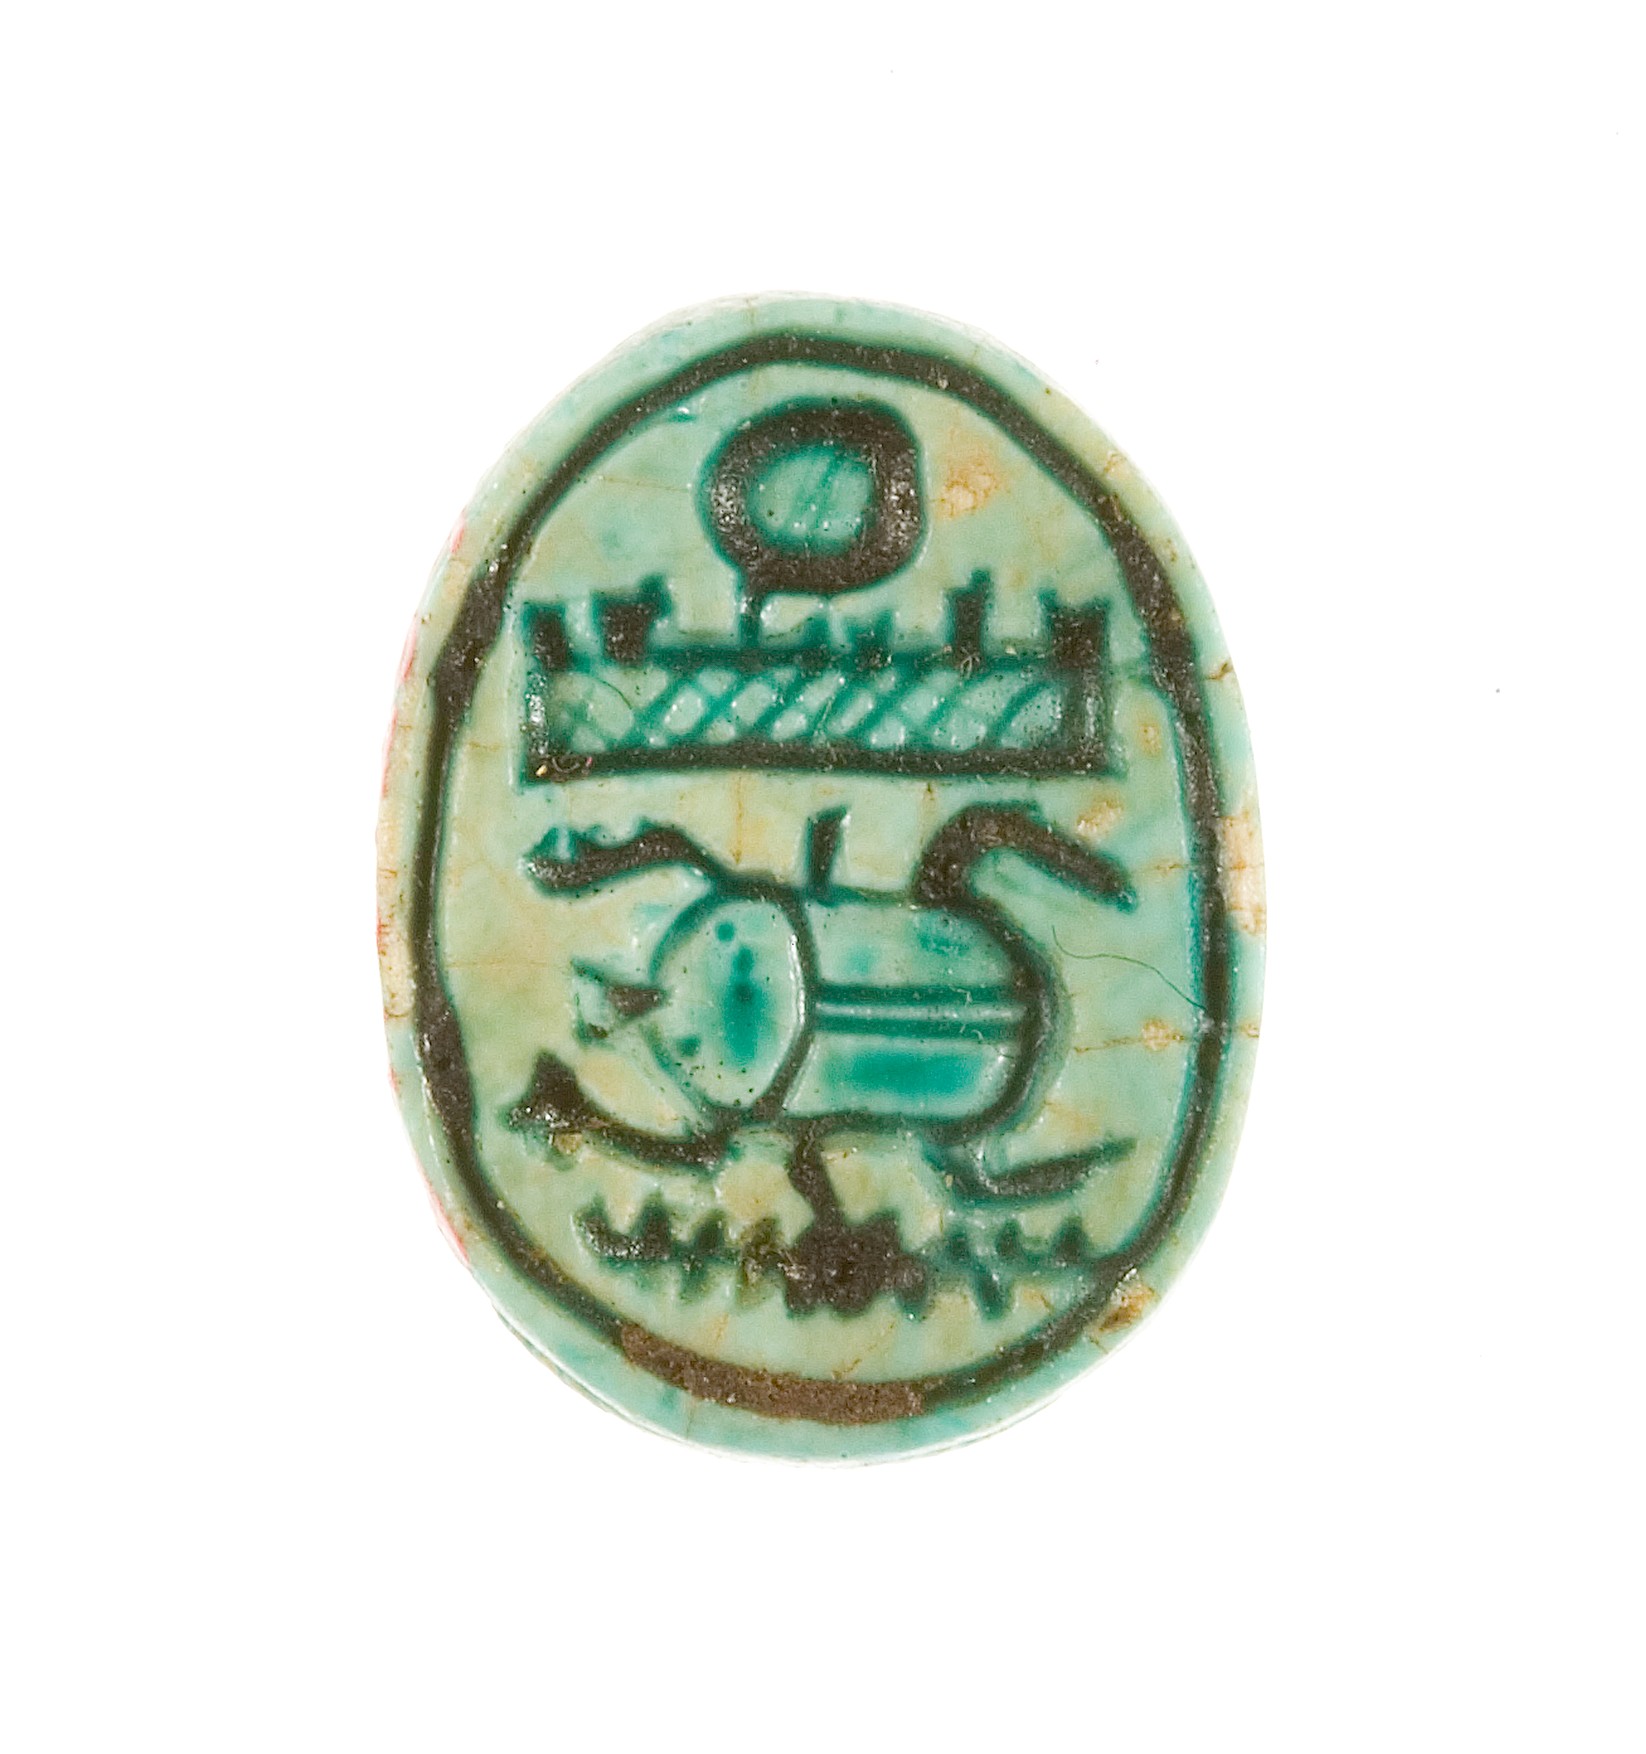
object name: scarab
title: Scarab Inscribed for Menkheperenre (Thutmose III)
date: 1479-1458 BCE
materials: stone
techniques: glazing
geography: egypt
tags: scarabs